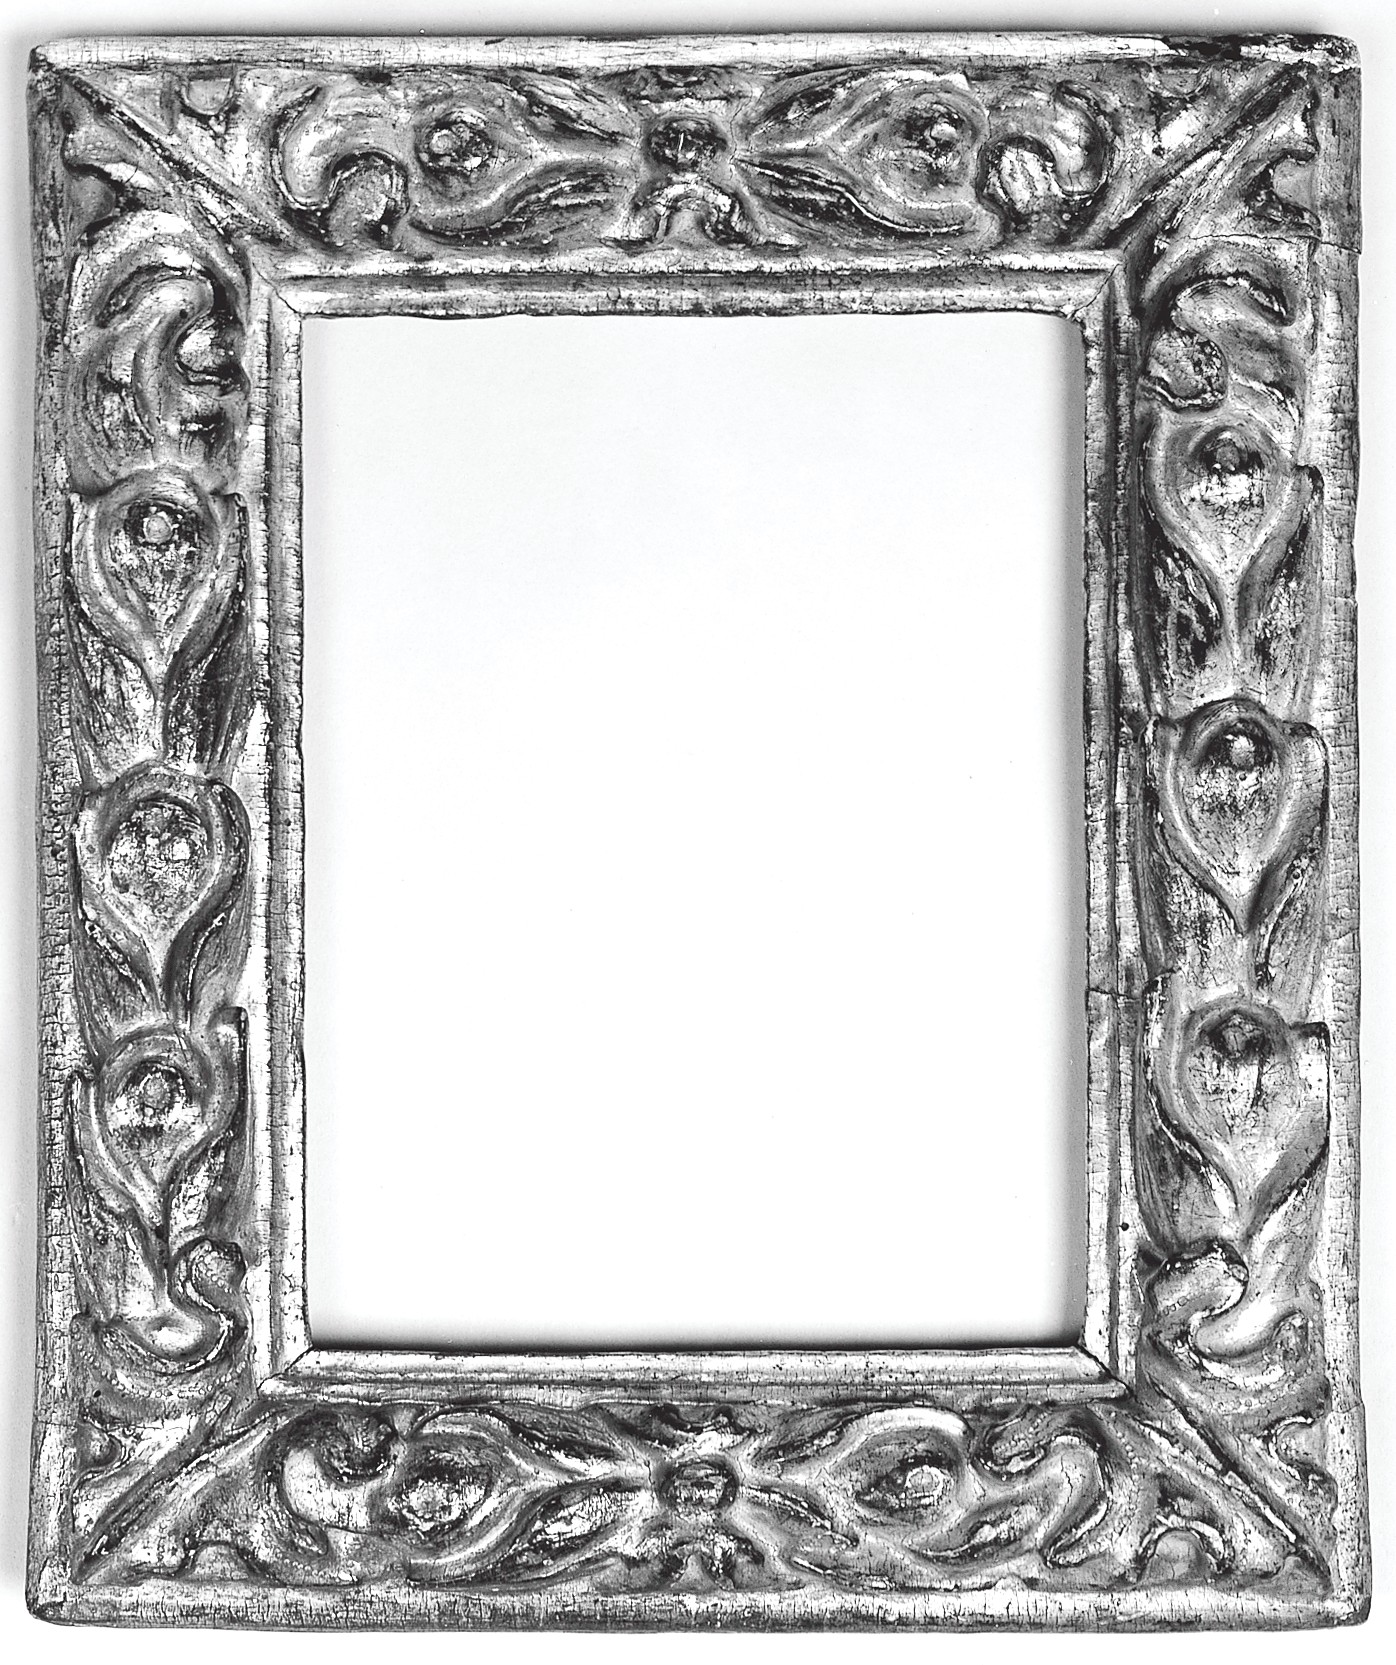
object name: frame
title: Astragal frame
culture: italian, veneto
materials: wood